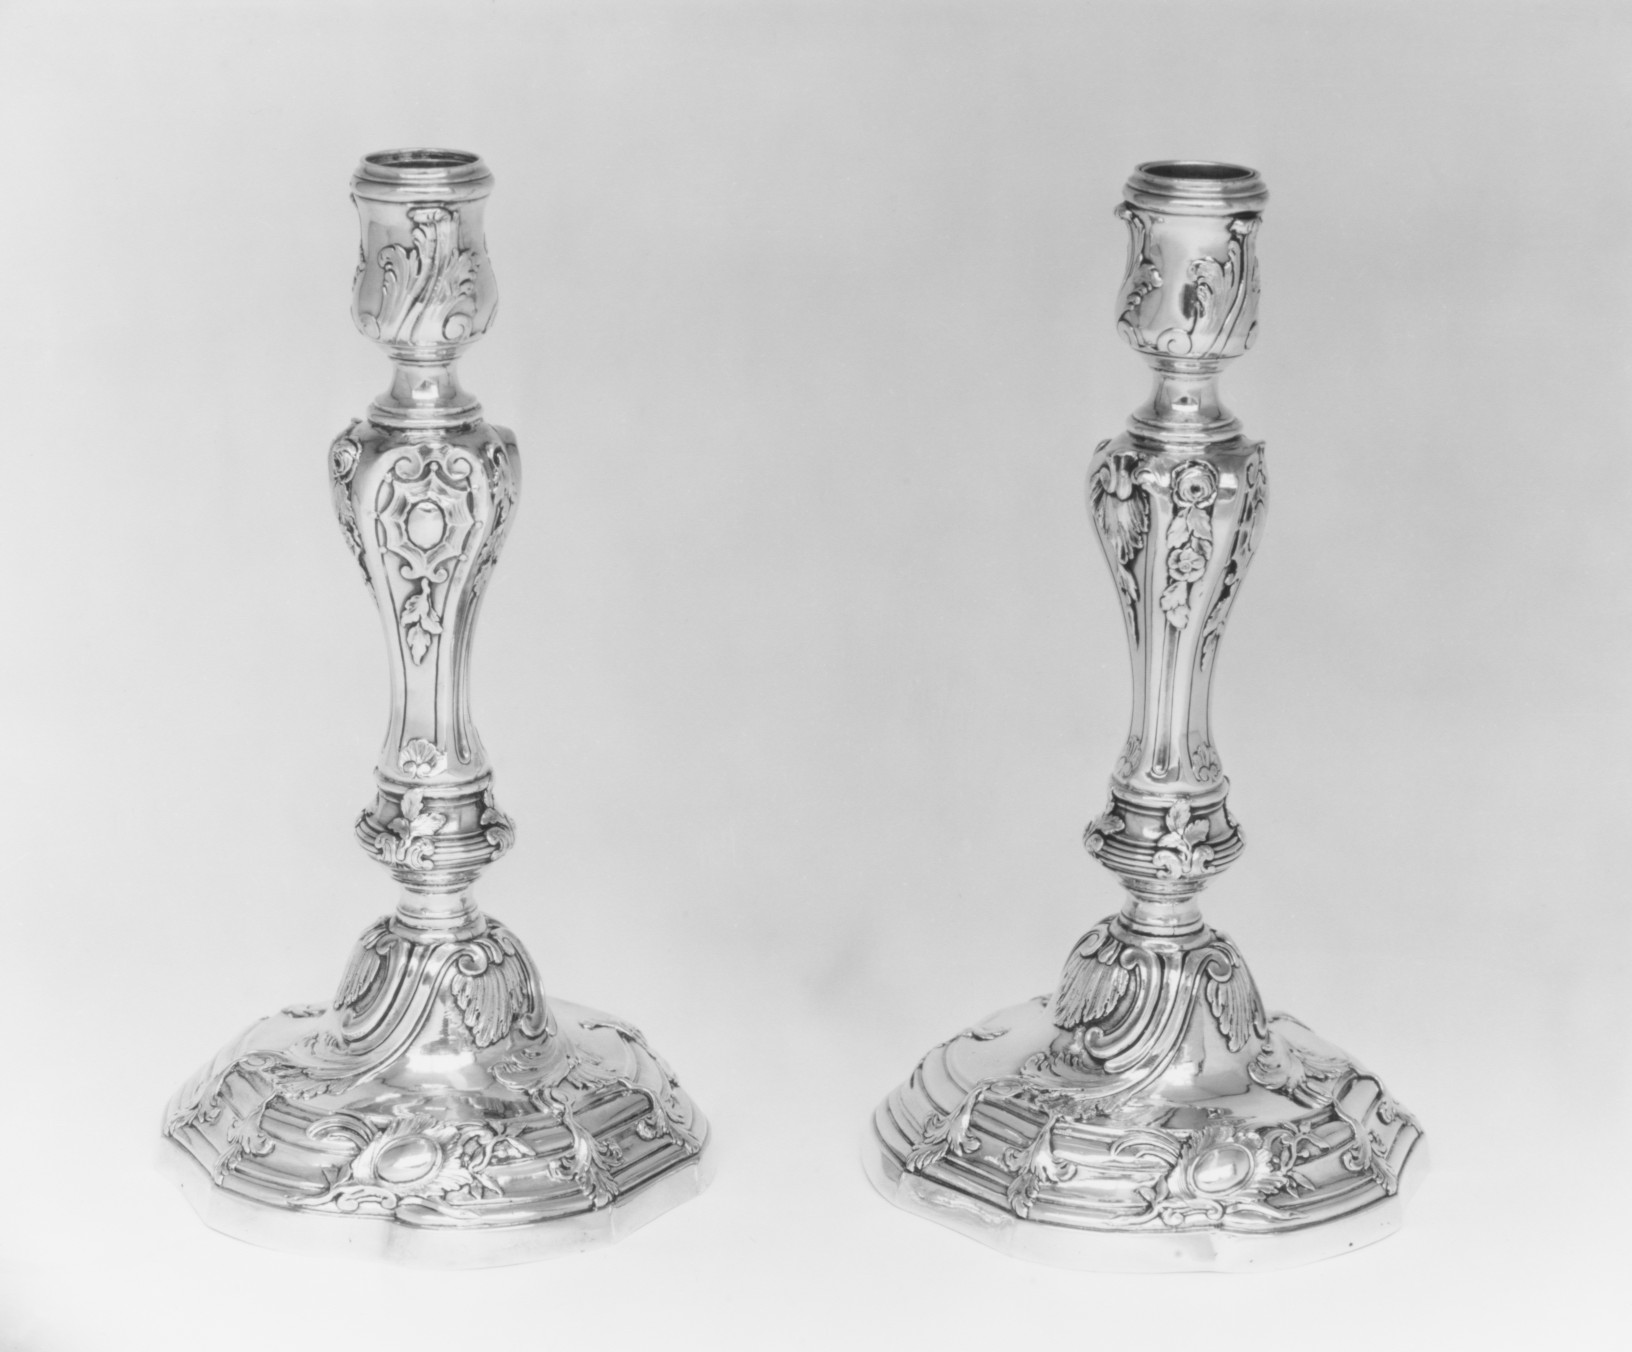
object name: candlestick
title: Pair of candlesticks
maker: guillaume ledoux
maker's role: maker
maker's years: 1651-1751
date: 1738-1739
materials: silver